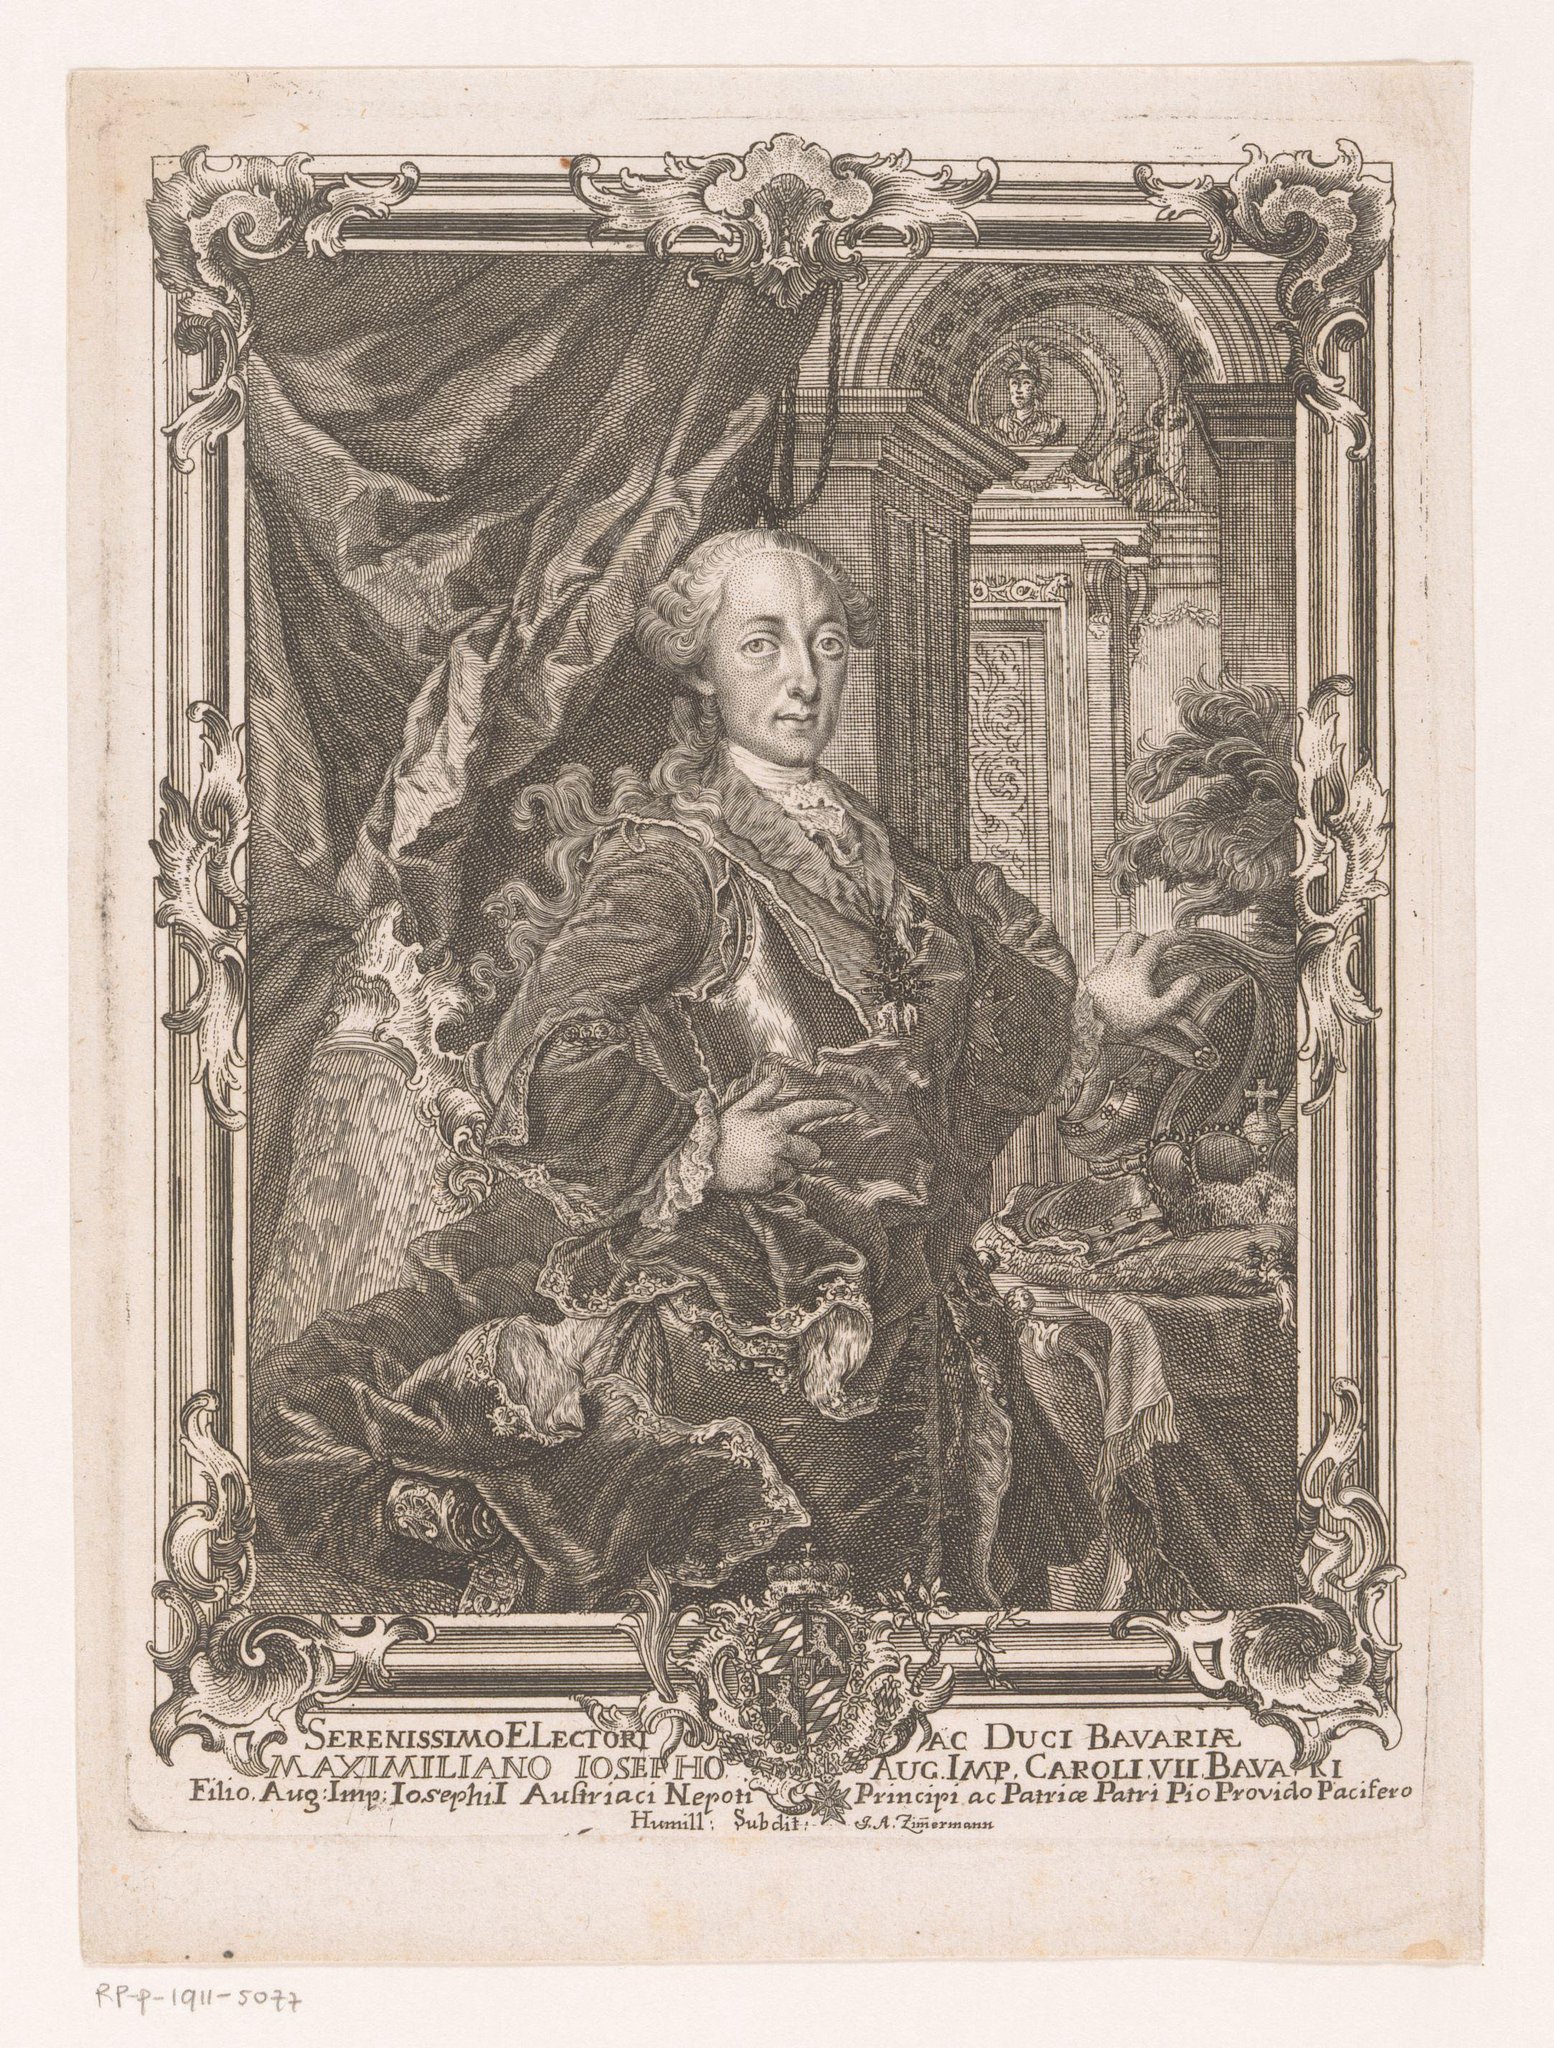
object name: print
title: Portret van Maximiliaan III Jozef van Beieren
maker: joseph anton zimmermann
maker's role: draughtsman, print maker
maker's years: 1705-1797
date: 1745-1797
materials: paper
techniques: engraving, etching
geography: germany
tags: historical persons, knighthood order of the golden fleece - insignia of a knighthood order, e.g.: badge, chain (with name of order)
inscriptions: collector's mark: Lugt 2228